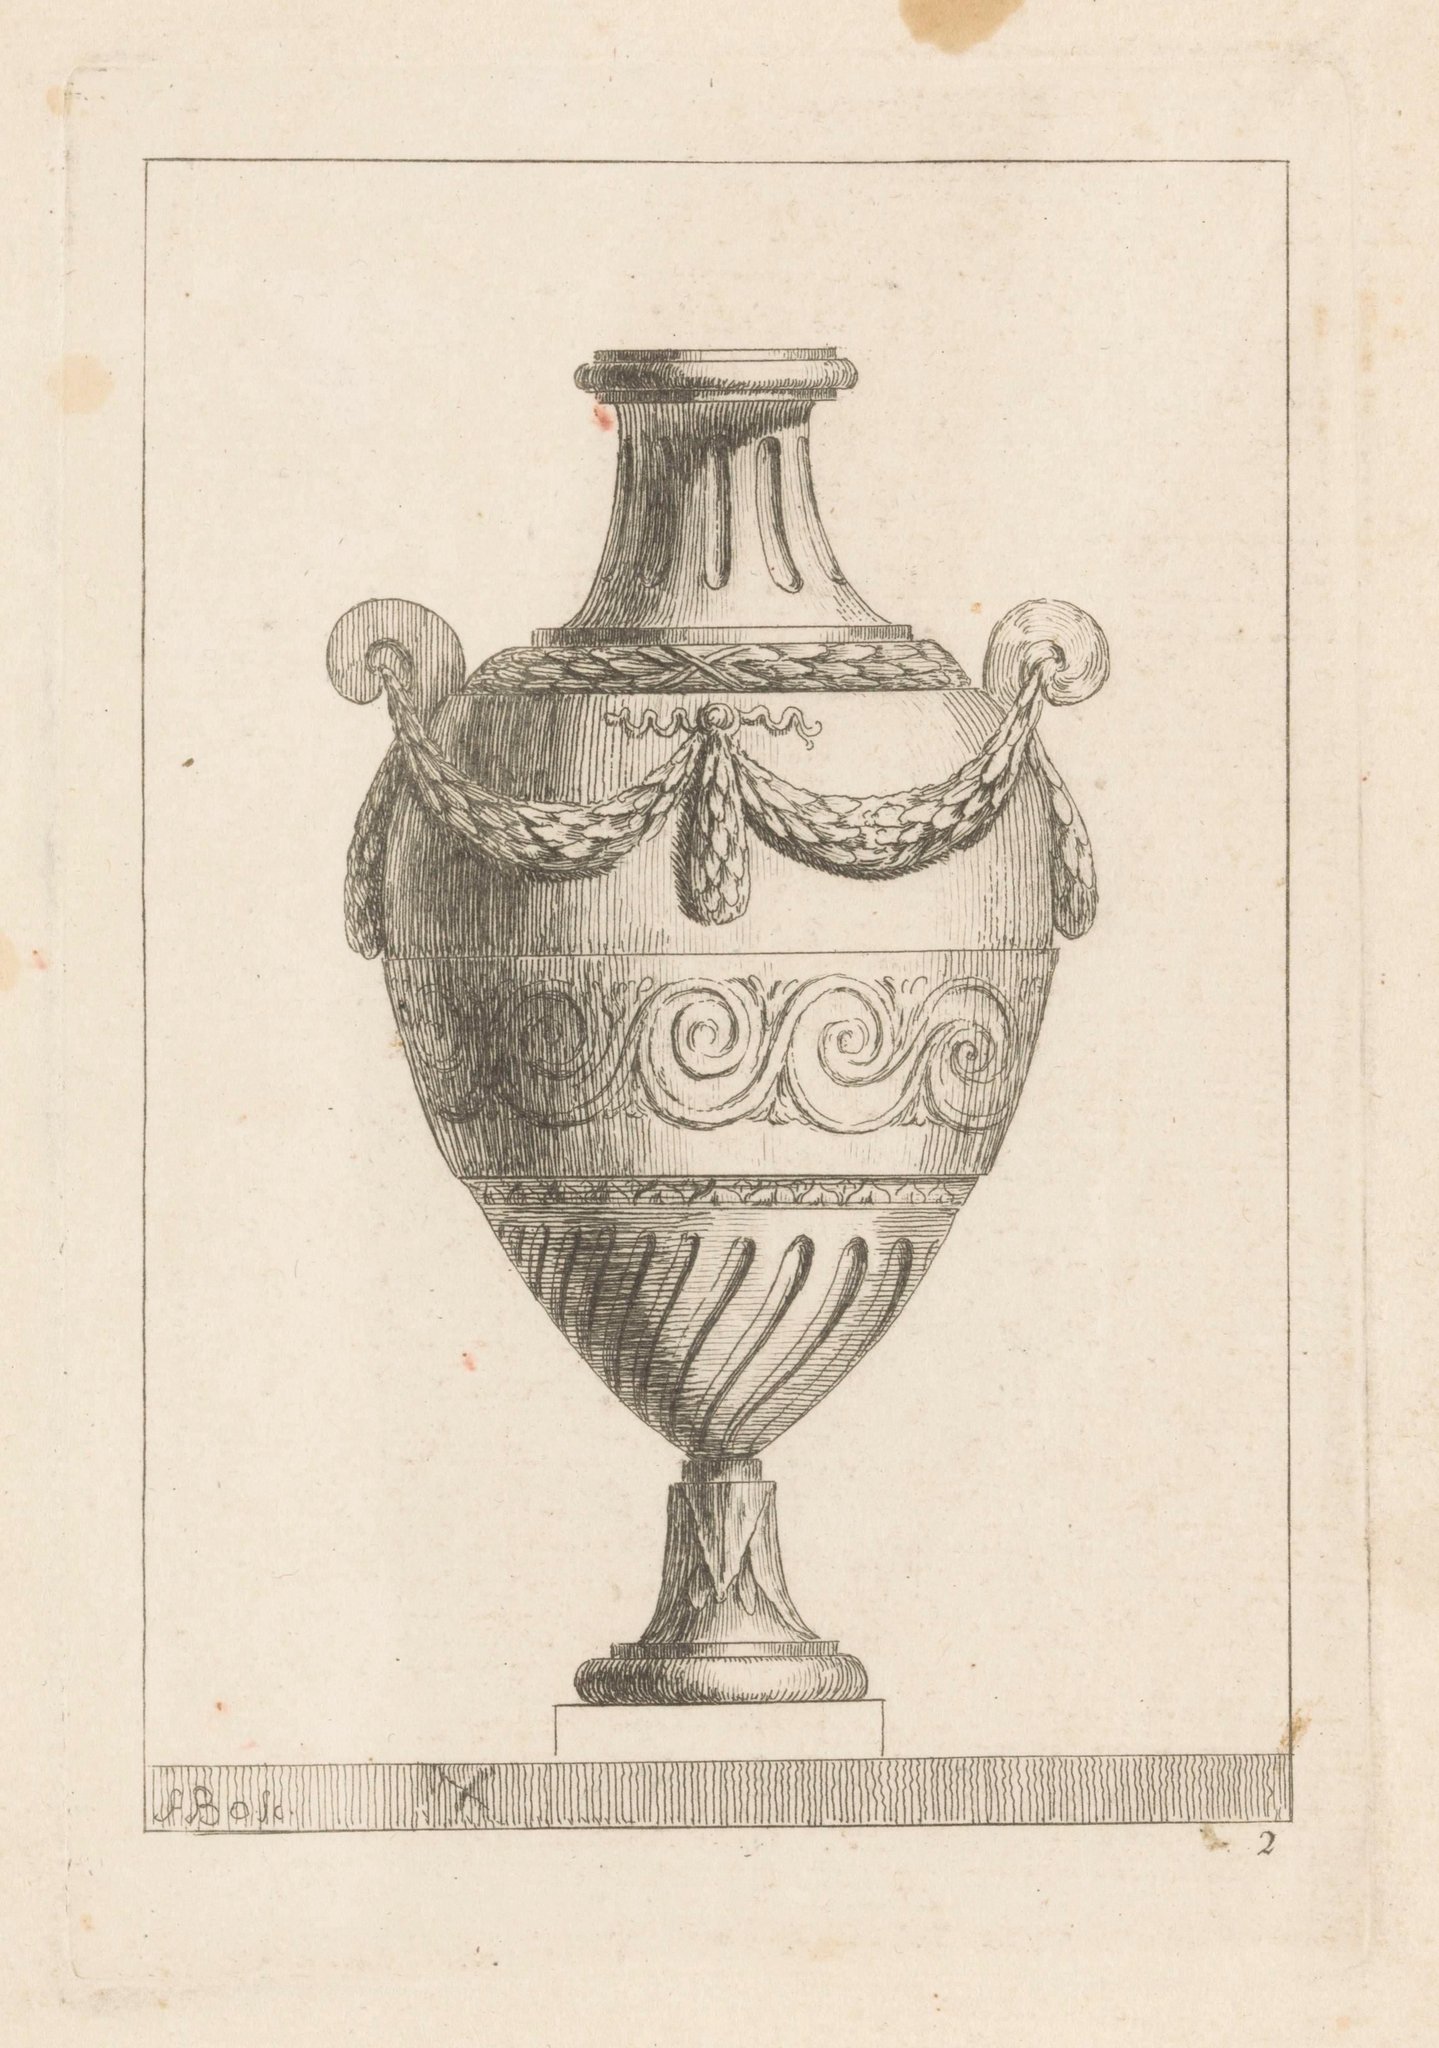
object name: print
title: Nouveau Livre de Vases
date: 1755-1782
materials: paper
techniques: etching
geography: paris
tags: vase ~ ornament, ornament ~ festoon, garland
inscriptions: collector's mark: Lugt 2228